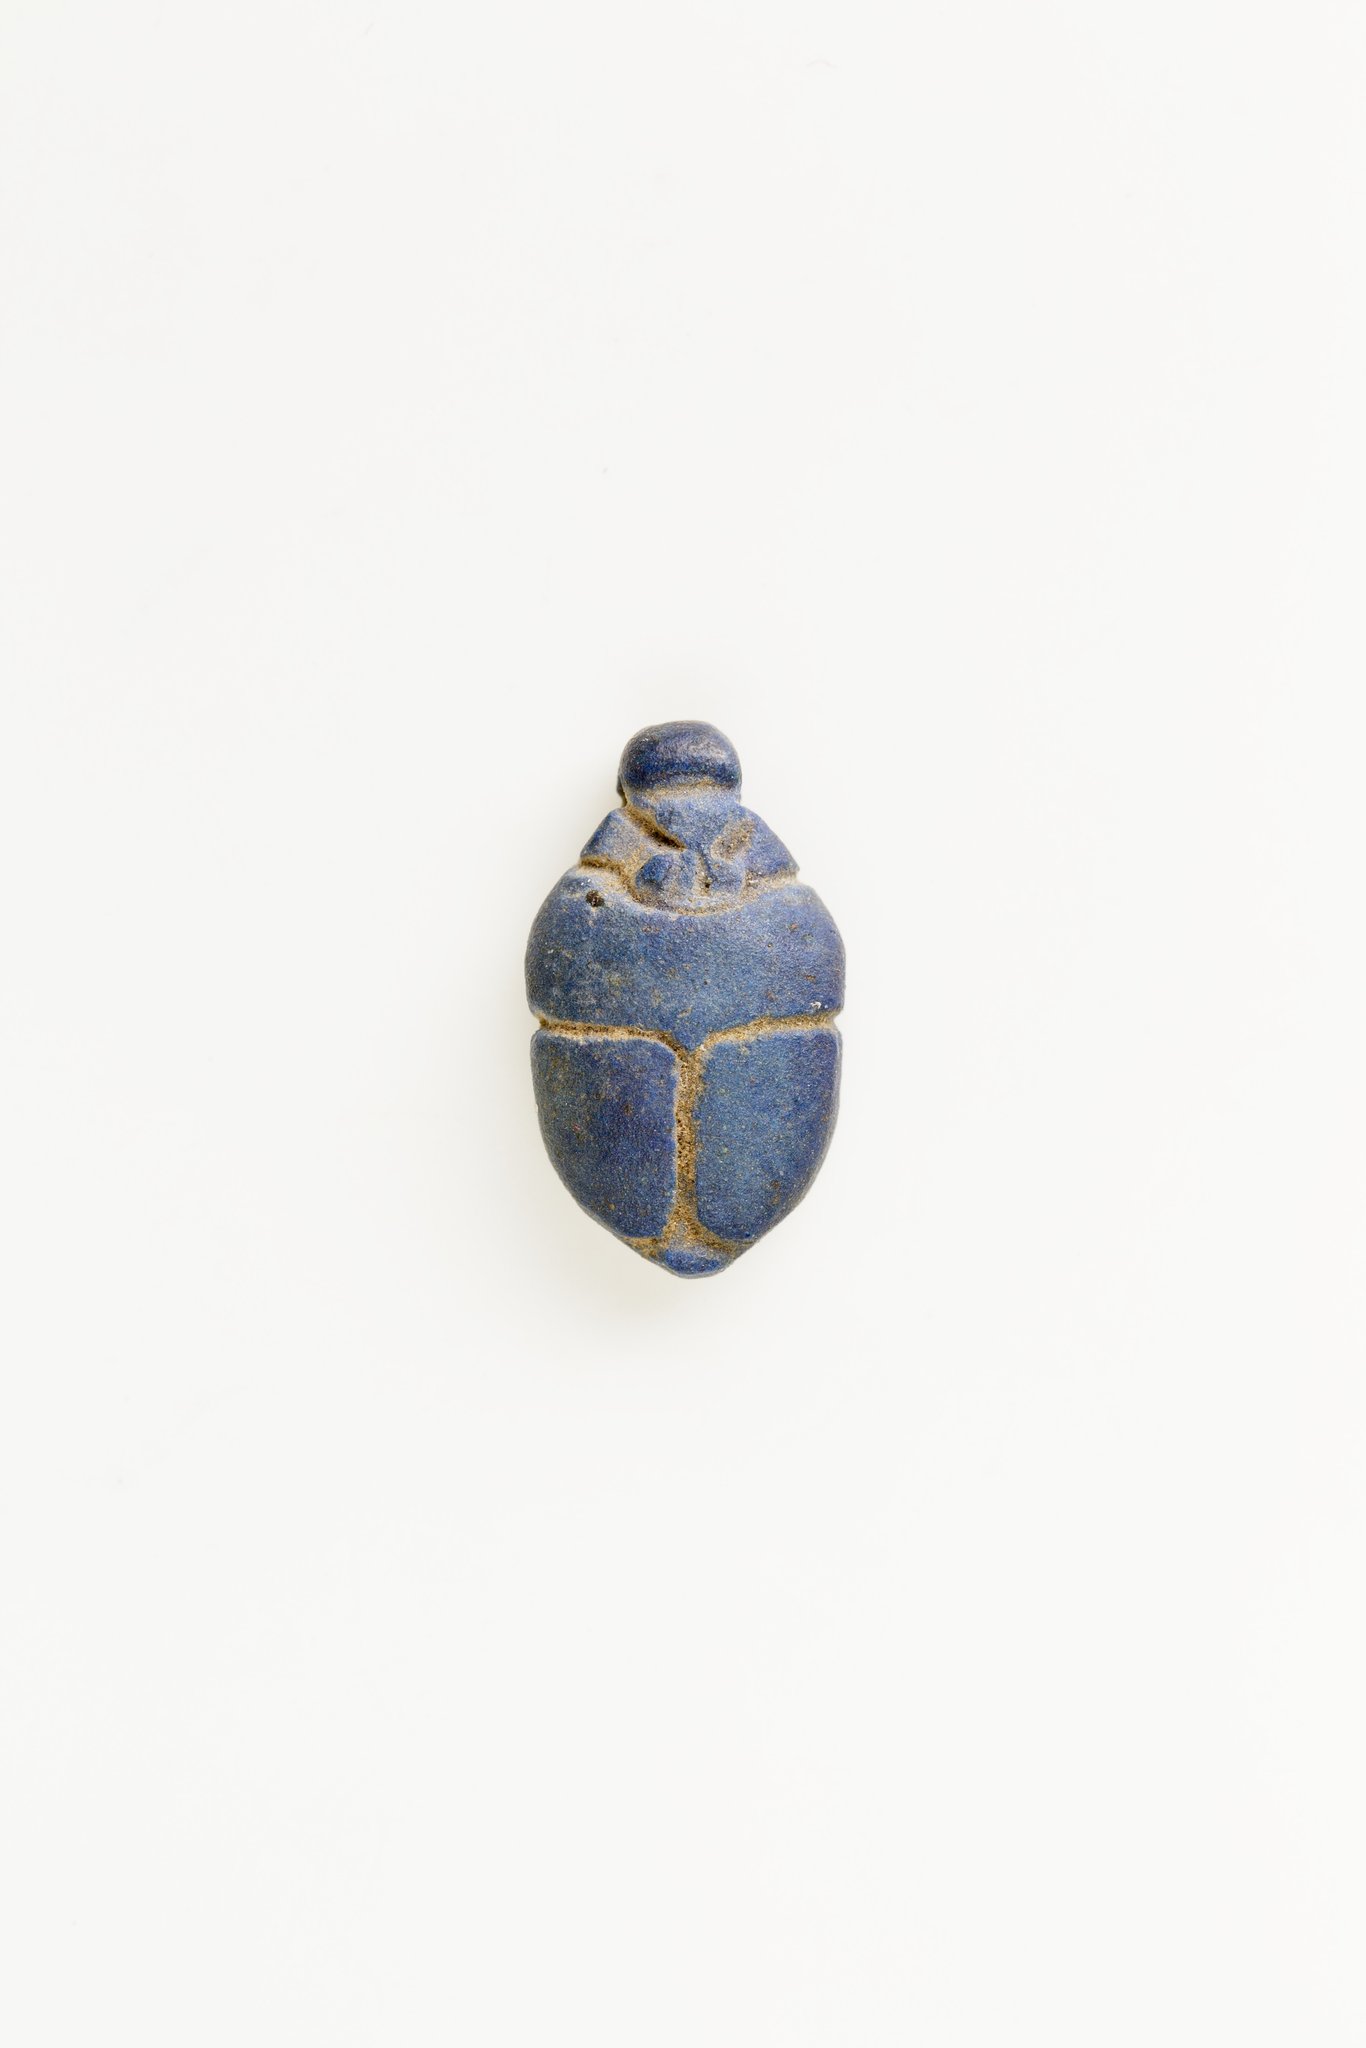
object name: scarab, from mummy, with loop at top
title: Scarab Amulet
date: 712-332 BCE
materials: paste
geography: egypt